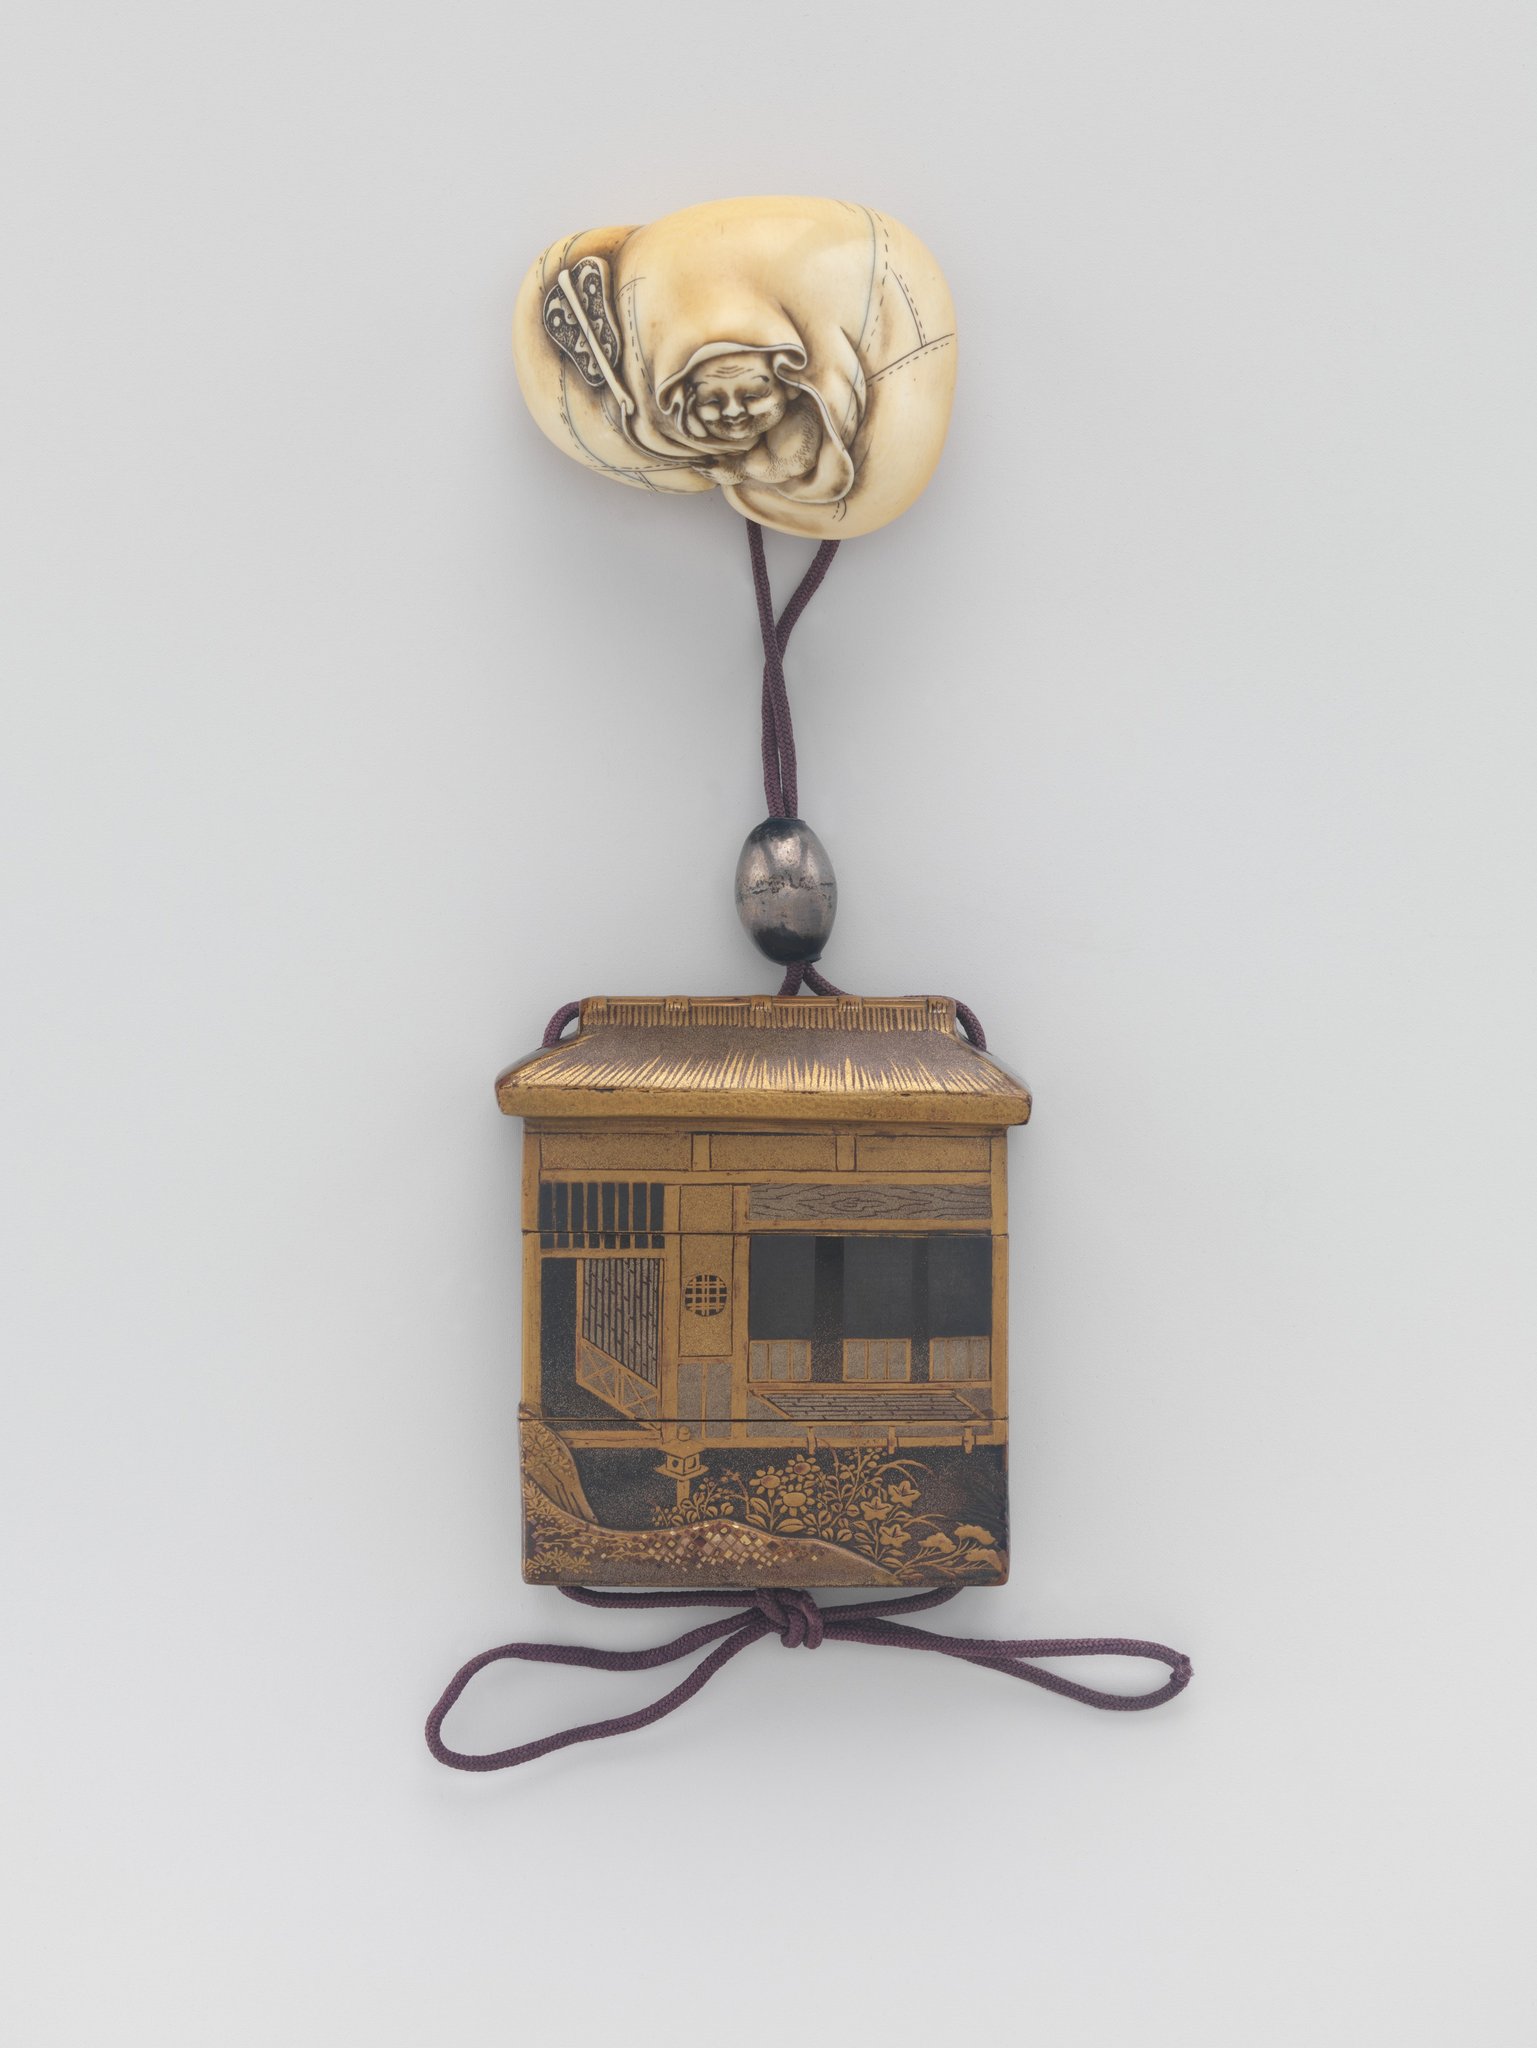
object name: inrō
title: Inrō in the Shape of a House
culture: japanese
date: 1767-1833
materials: gold, gold foil, ivory, lacquer, metal, silver, wood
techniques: hiramakie, lacquer, maki-e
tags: houses